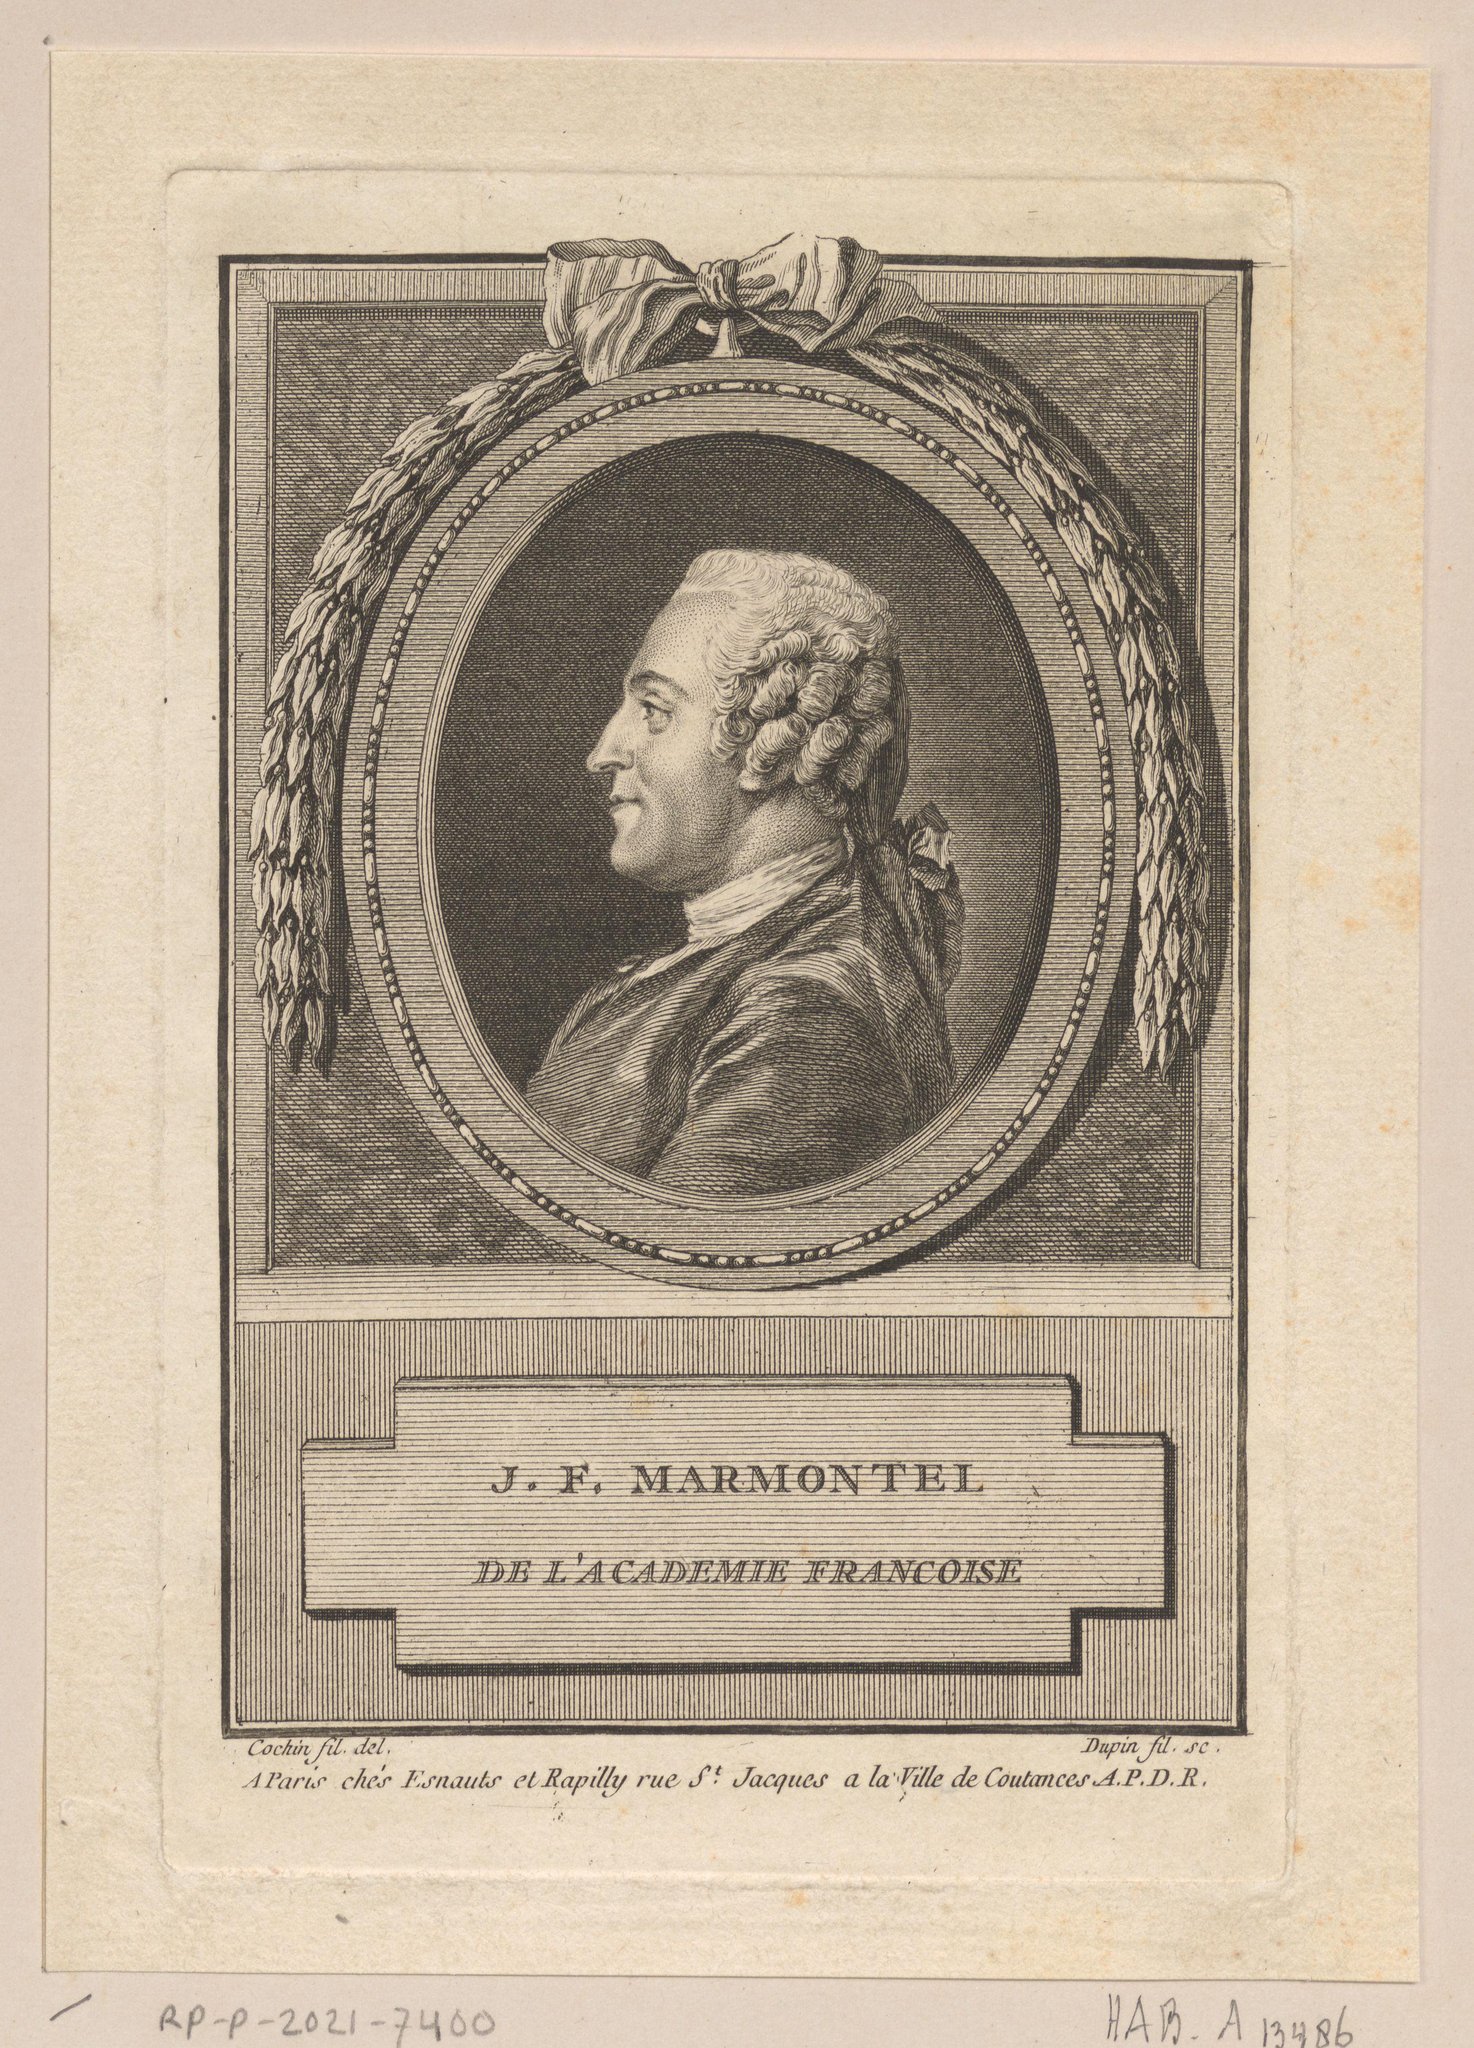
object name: print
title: Portret van Jean-François Marmontel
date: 1766-1786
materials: paper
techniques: engraving, etching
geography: paris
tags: jean françois marmontel, ornament ~ medallion, historical persons, portrait of a writer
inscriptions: number: ‘1635’